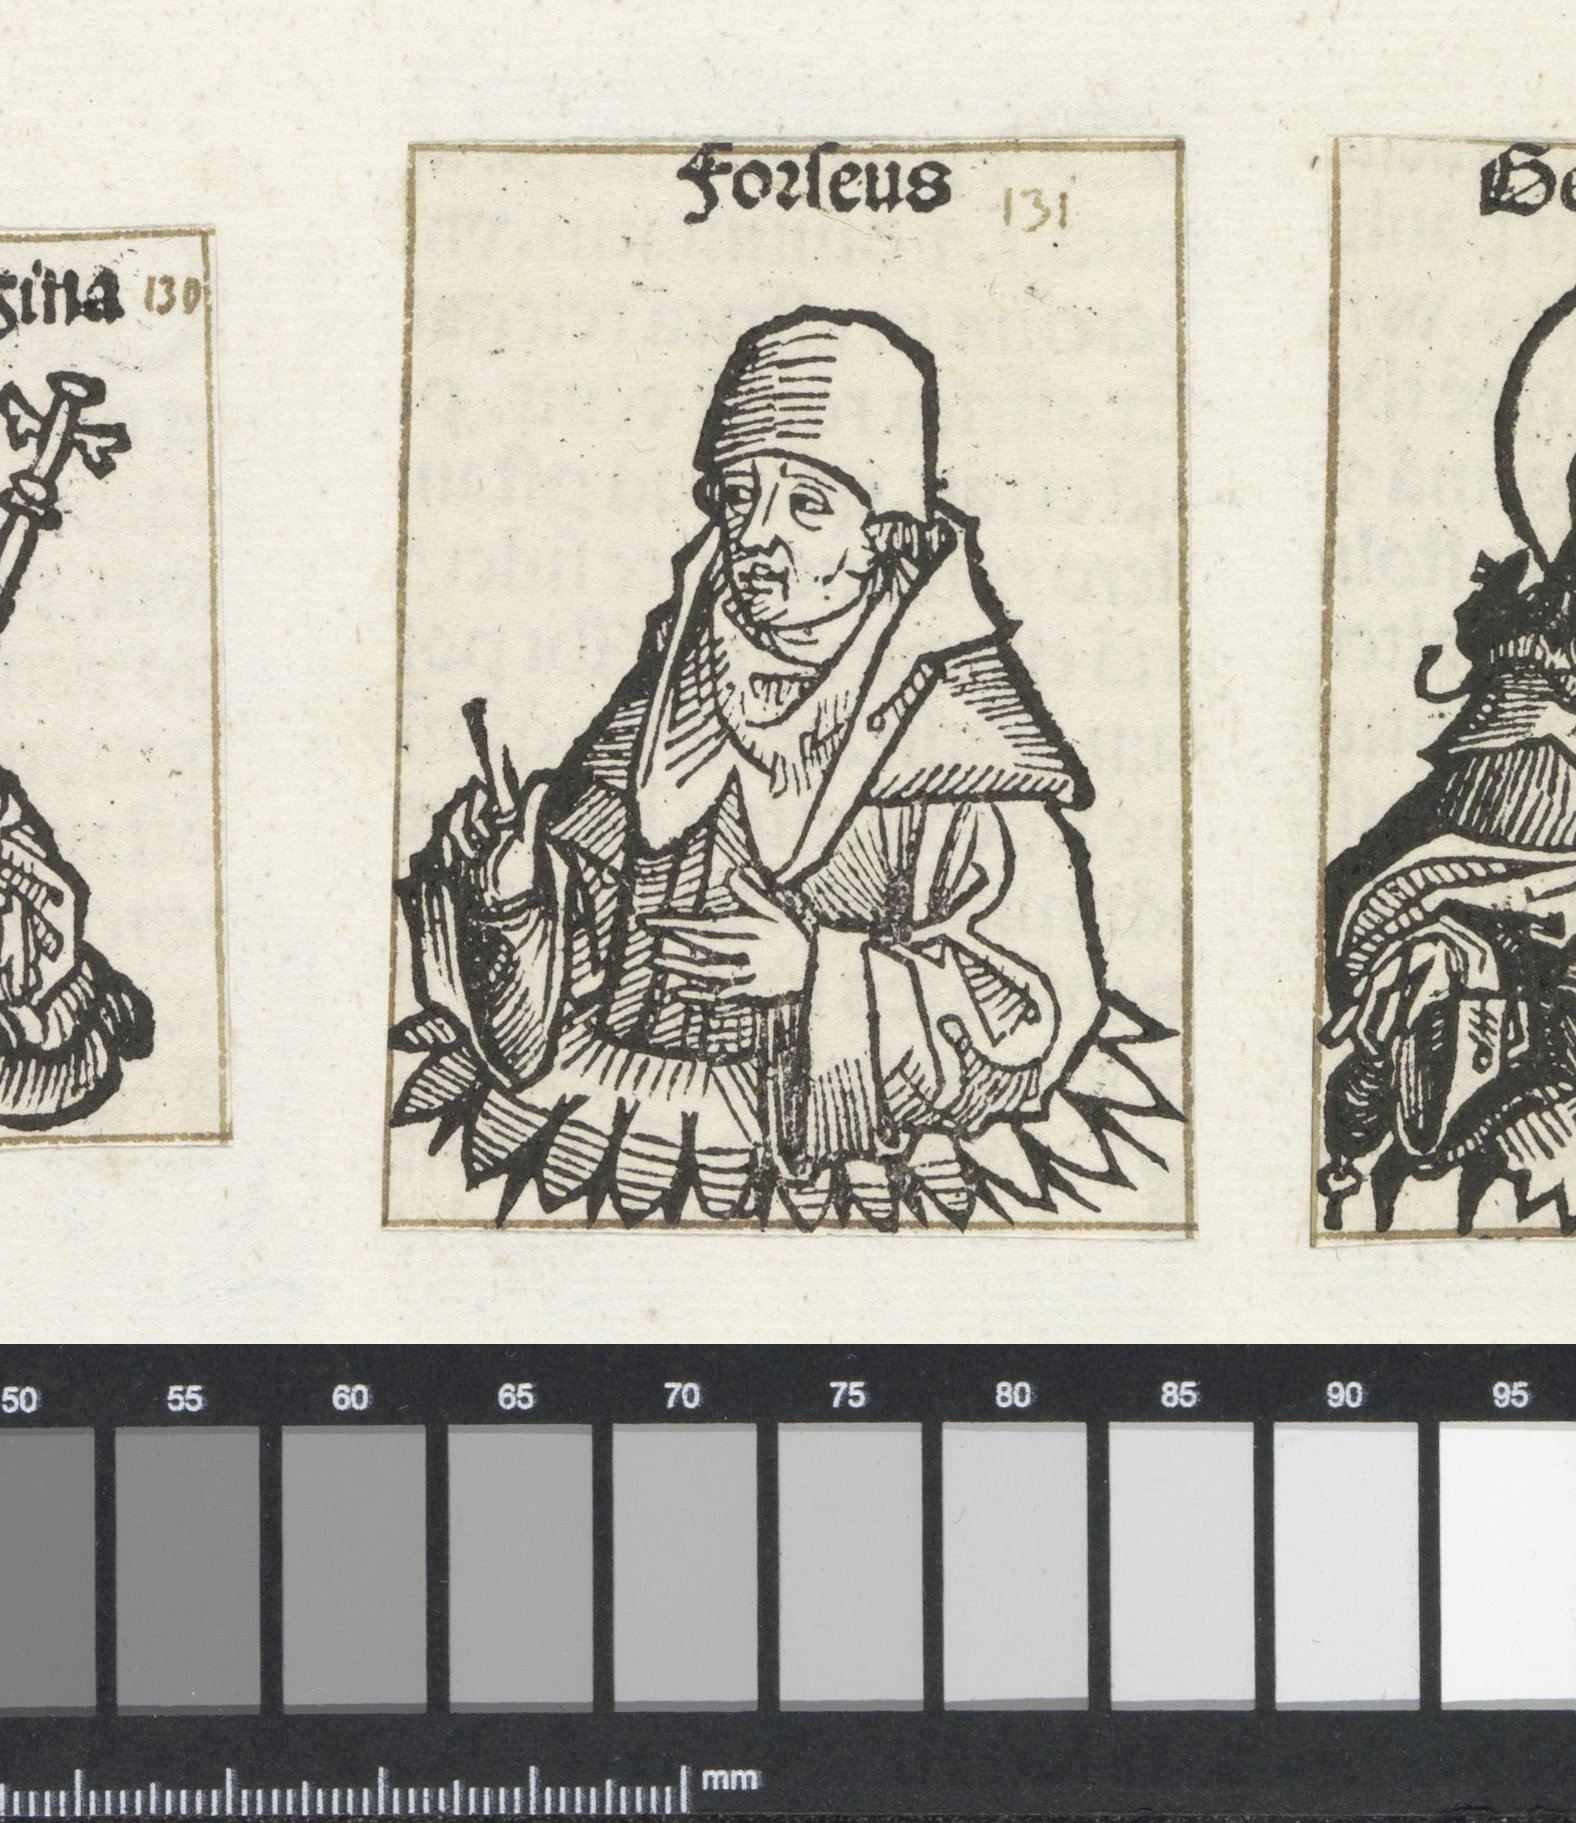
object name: print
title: Forseus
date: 1493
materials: paper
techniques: letterpress printing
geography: nuremberg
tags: saints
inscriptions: inscription: ‘131’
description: De houtsnede wordt herhaaldelijk gebruikt als boekillustratie in de Liber Chronicarum (of Neurenbergkroniek) van Hartmann Schedel, verschenen in het Latijn en Duits in 1493. Zie de Latijnse uitgave, folio 154v.